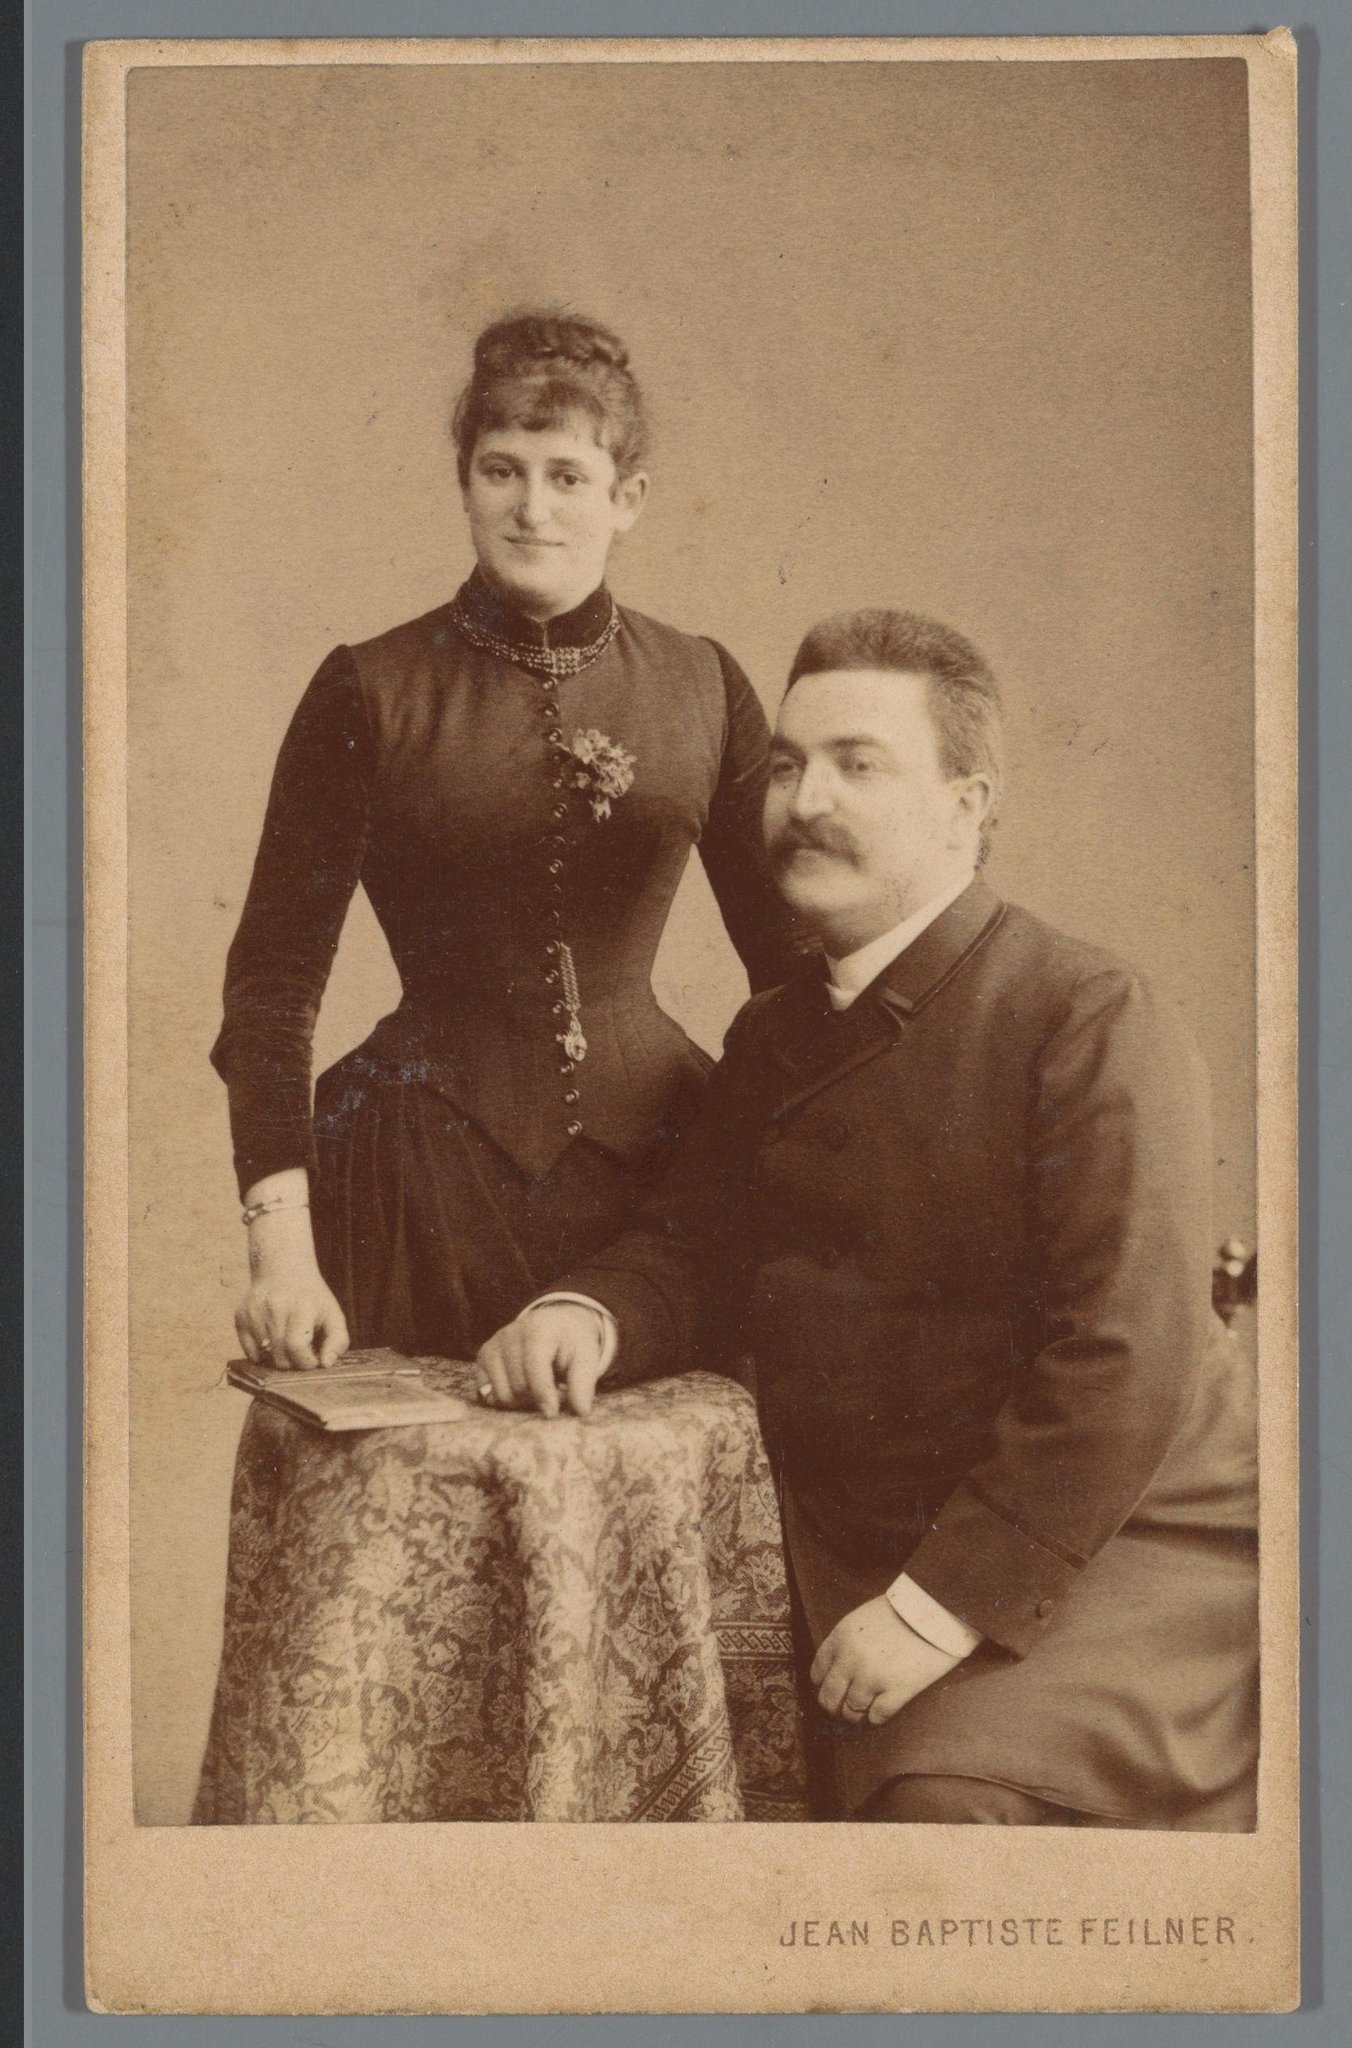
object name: photograph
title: Portret van een onbekende man en vrouw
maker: jean baptiste feilner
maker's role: fotograaf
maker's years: 1844-1912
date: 1885-1900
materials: cardboard, paper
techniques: albumen print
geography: bremen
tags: adult woman, adult man, anonymous historical person portrayed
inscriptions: inscription: ‘Jean Baptiste Feilner/ Hof-Photograph/ d.Erbgrossherzogs/ Sr. Königl. Hoheit/ von Oldenburg./ Bremen/ Richtweg 6b, Parterre./ Oldenburg/ Rosenstrasse 26./ Braunschweig/ südliche Wilhelmstr. 88.’, inscription: ‘Jean Baptiste Feilner’